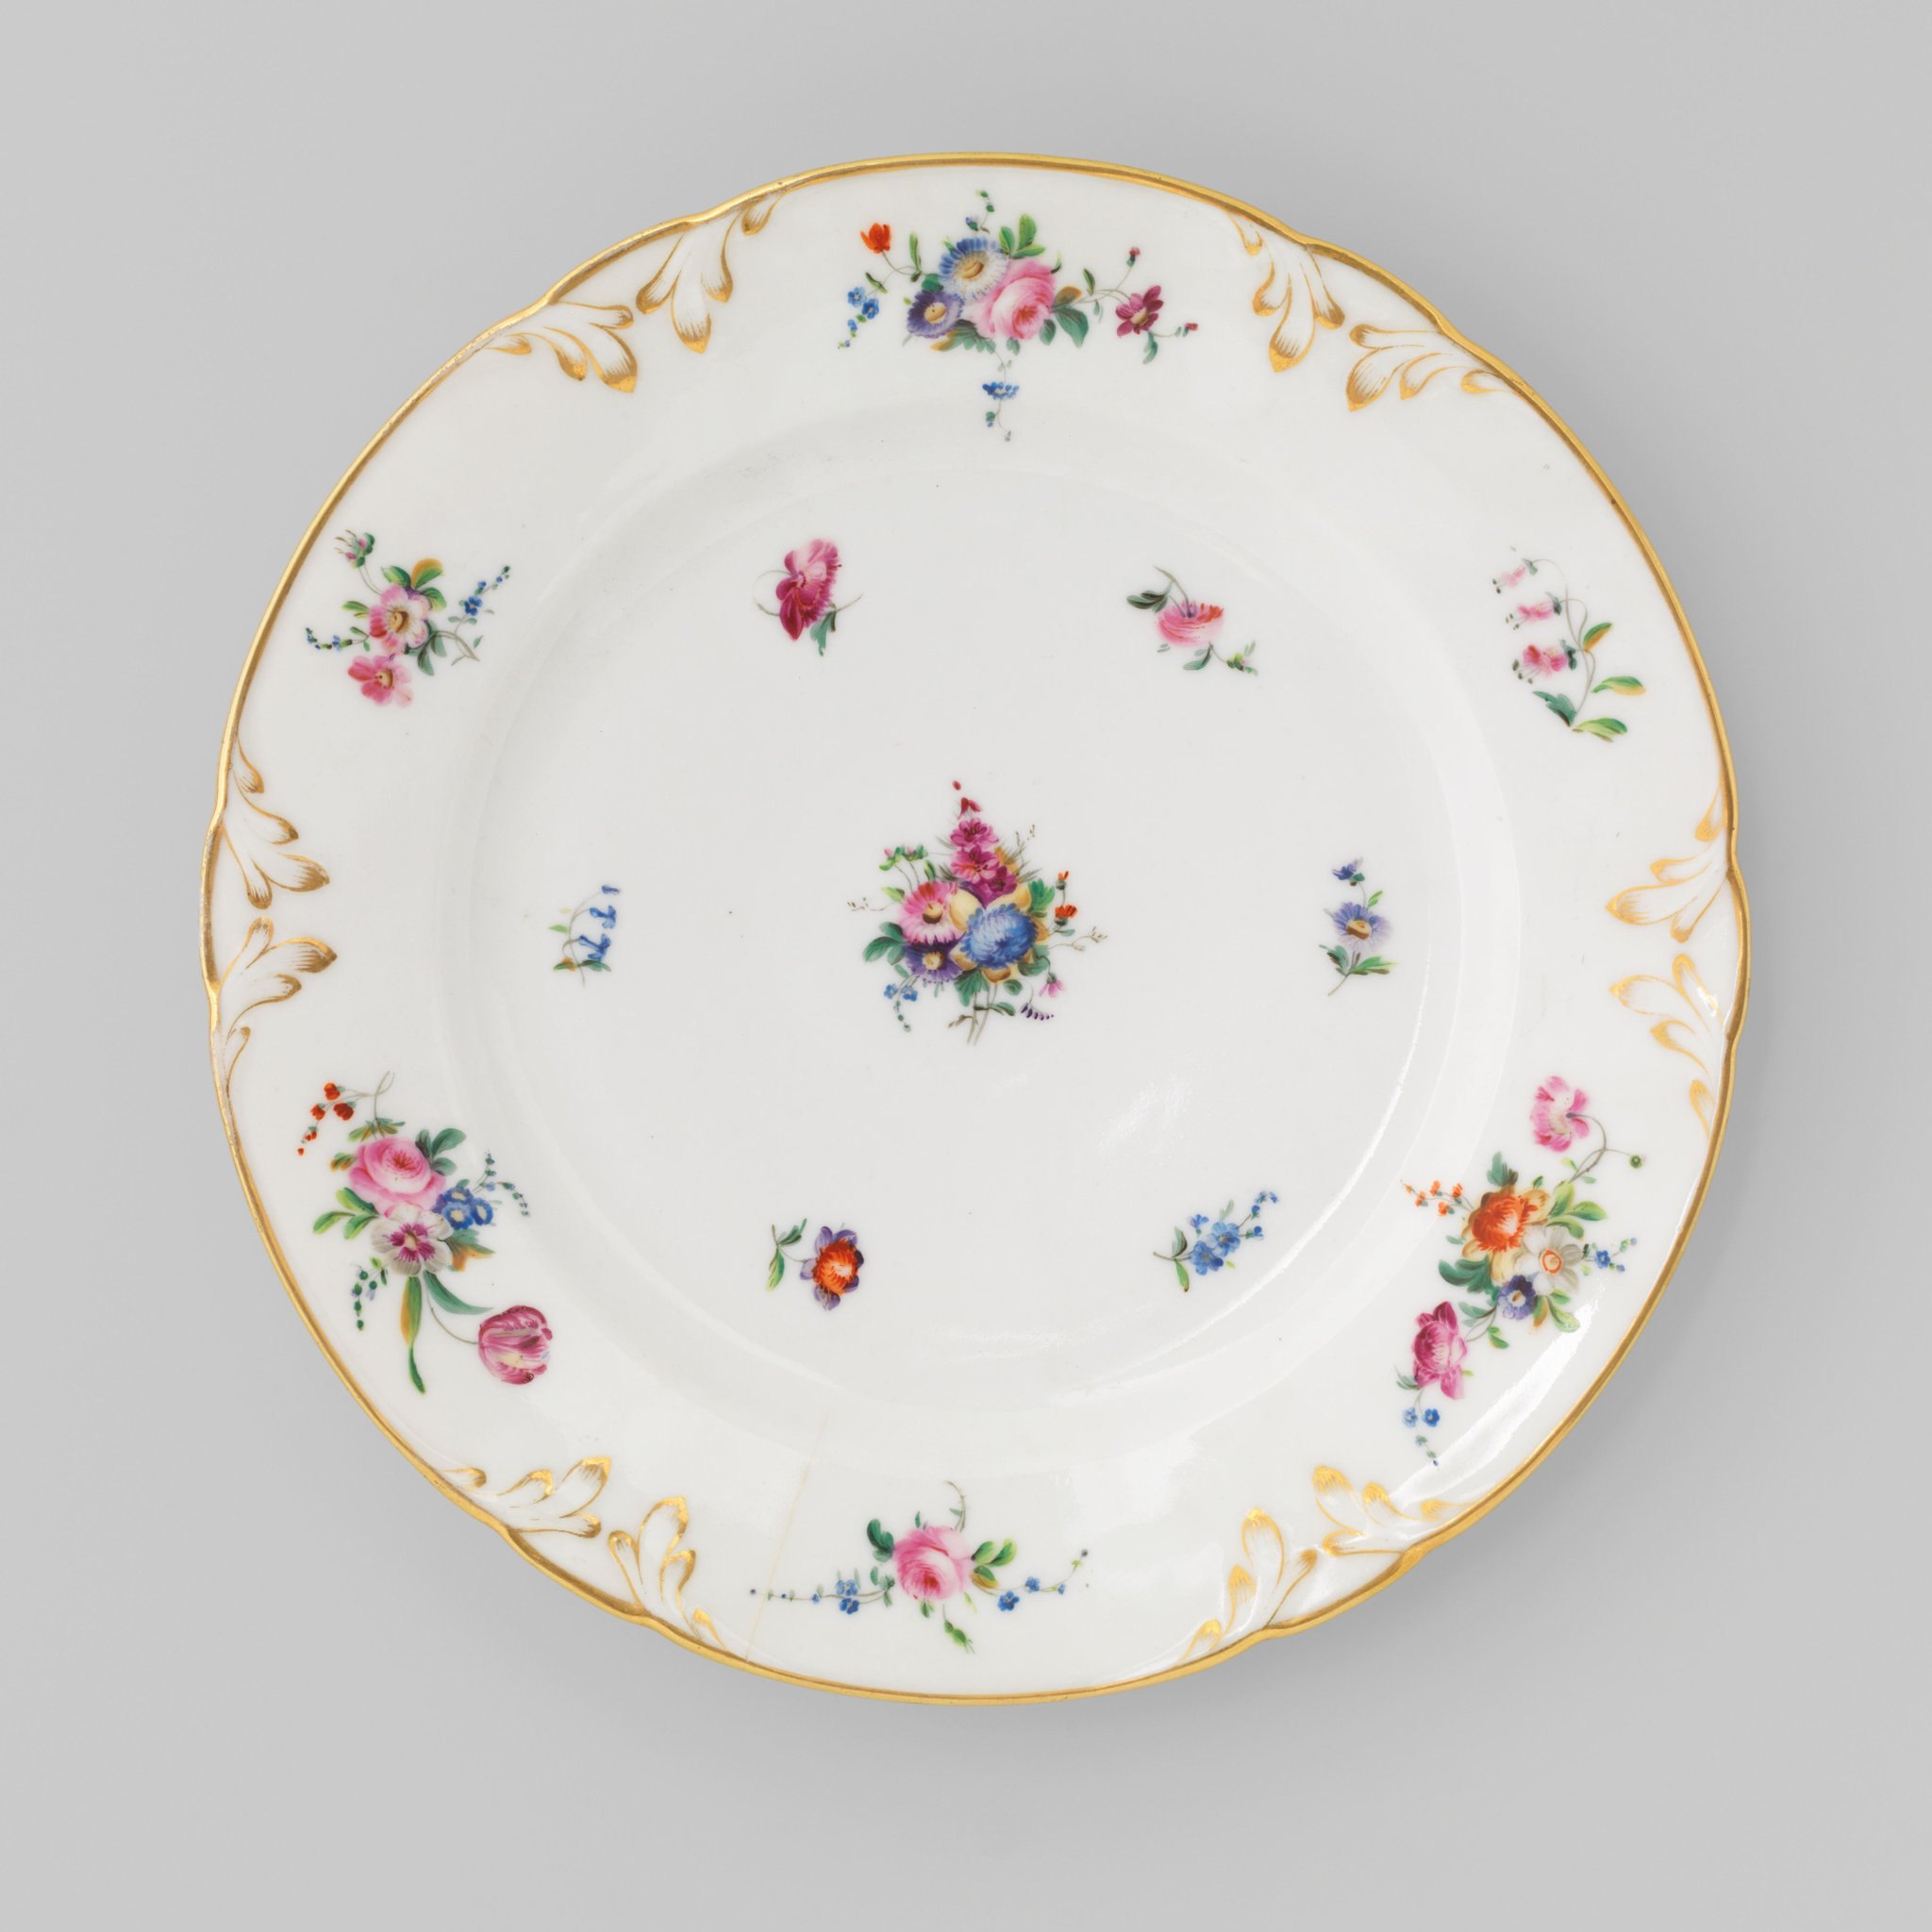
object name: plate dish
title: Plate with bouquets and flower sprays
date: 1839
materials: glaze, gold, paint, porcelain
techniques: firing, forming, gilding, turning, vitrification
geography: paris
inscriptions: mark: ‘DENUELLE/ Boulevard St. Denis 18/ à Paris’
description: Bord (dessertbord) van porselein met een gelobde rand, beschilderd op het glazuur in blauw, rood, roze, groen, geel, paars, zwart en goud. Op het plat boeketten van verschillende bloemen en strooibloemen. Vanuit de gelobde, gouden rand, gemodelleerde bladranken in reliëf, aangezet met goud. Hiertussen boeketten. Drie proenen op de onderzijde. Gemerkt op de onderzijde met 'DENUELLE/ Boulevard St. Denis 18/ à Paris'.